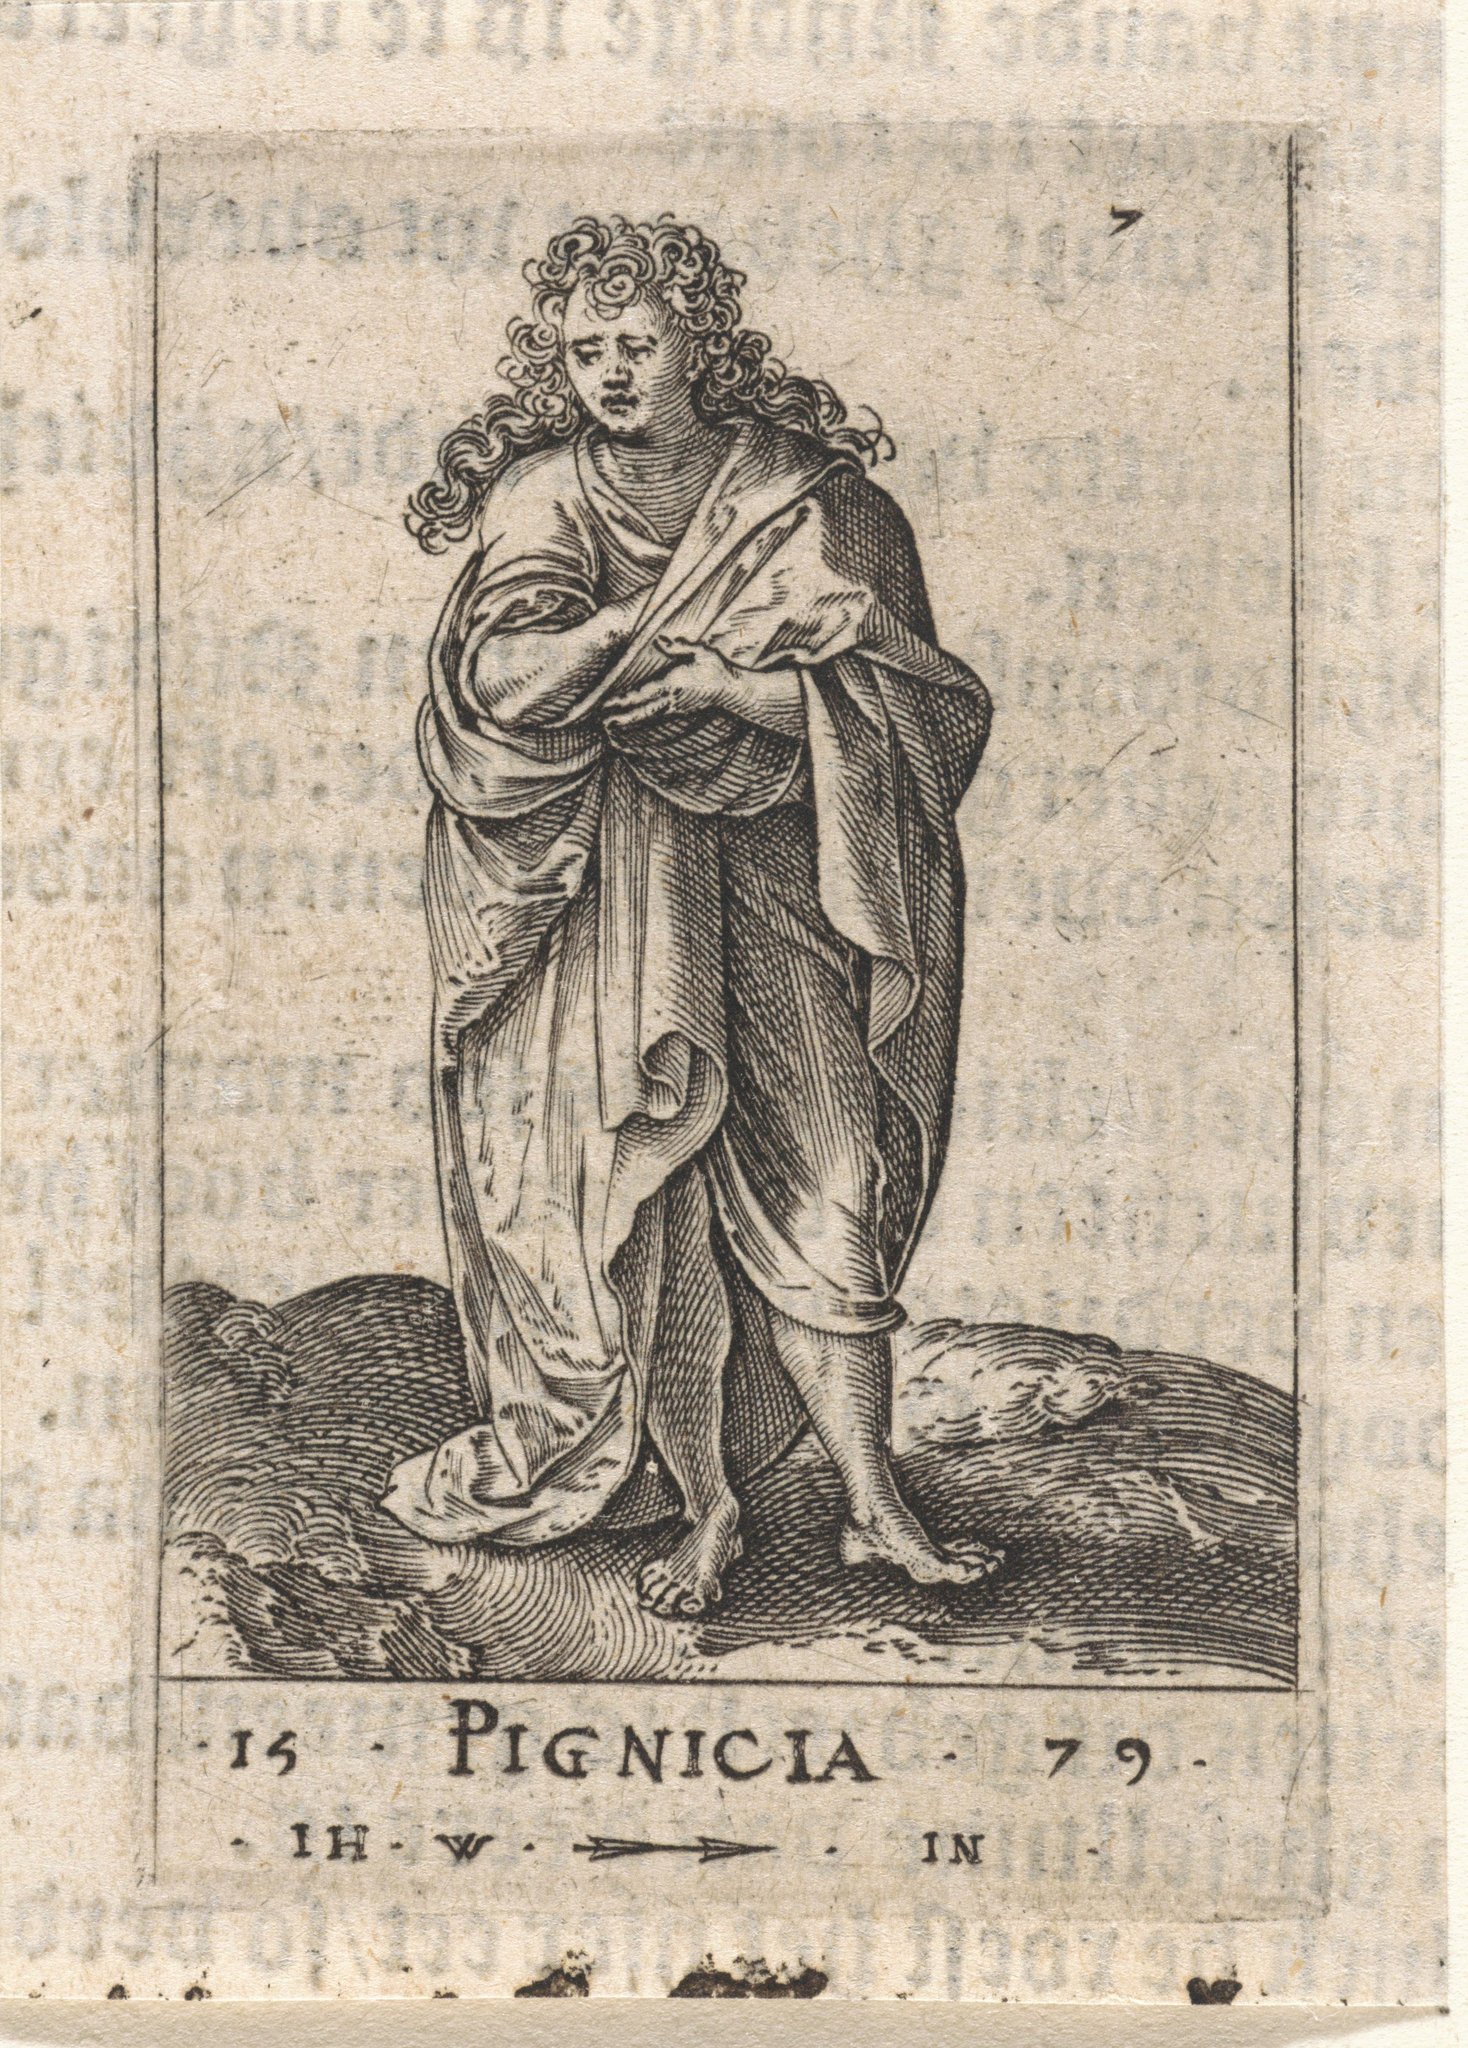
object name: book illustration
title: Zeven hoofdzonden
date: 1579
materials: paper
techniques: engraving, letterpress printing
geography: antwerp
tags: sloth, indolence, 'acedia', 'desidia'; 'accidia' (ripa) ~ personification of one of the seven deadly sins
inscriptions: collector's mark: Lugt 2228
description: Prent gebruikt als illustratie in: Const-toonneel, inhoudende de beschrijvinghe ende XL. Heerlijcke afbeeldindinghen: Onses Heeren Jesu Christi, met sijne apostelen, ende evangelisten, midtsgaders de hooft-deuchden ende ondeuchden. Ende ten laetsten de seven planeten. In coper gesneden door Johannis Wierix. De beschrijvinge is (...). Delft: Nicolaes de Clerck, 1609.